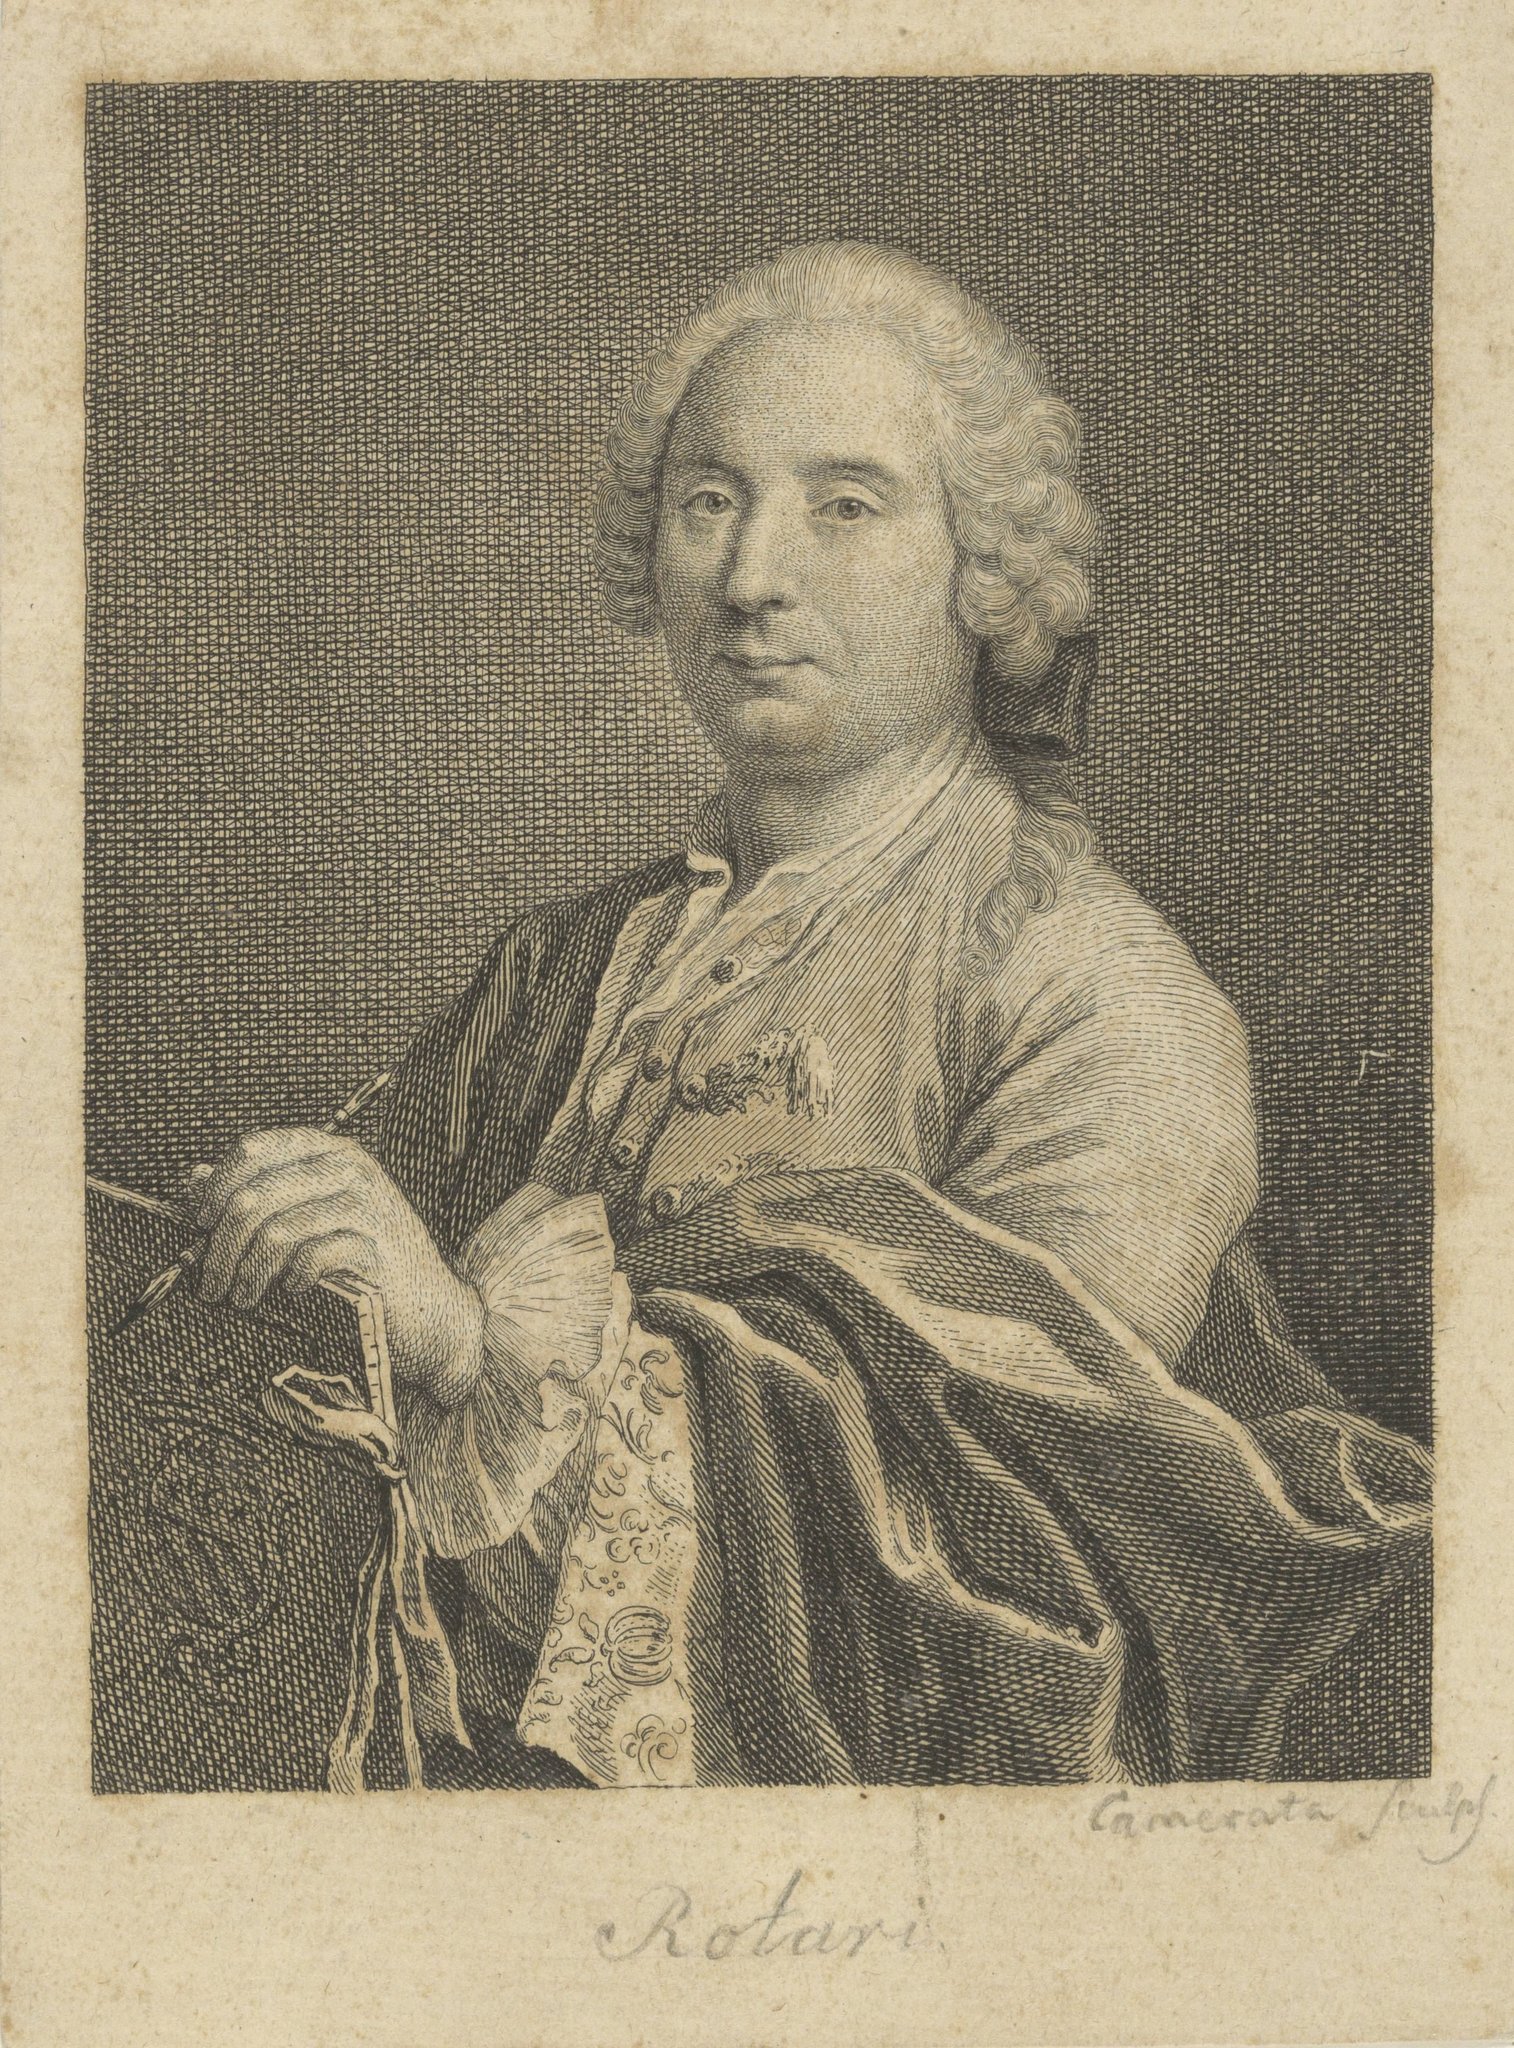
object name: print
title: Portret van de schilder Pietro Rotari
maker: giuseppe camerata (ii)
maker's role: print maker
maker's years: 1718-1803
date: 1728-1803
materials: paper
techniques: engraving, etching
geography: italy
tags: painter, pietro rotari, historical persons, portrait, self-portrait of artist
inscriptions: collector's mark: Lugt 2228